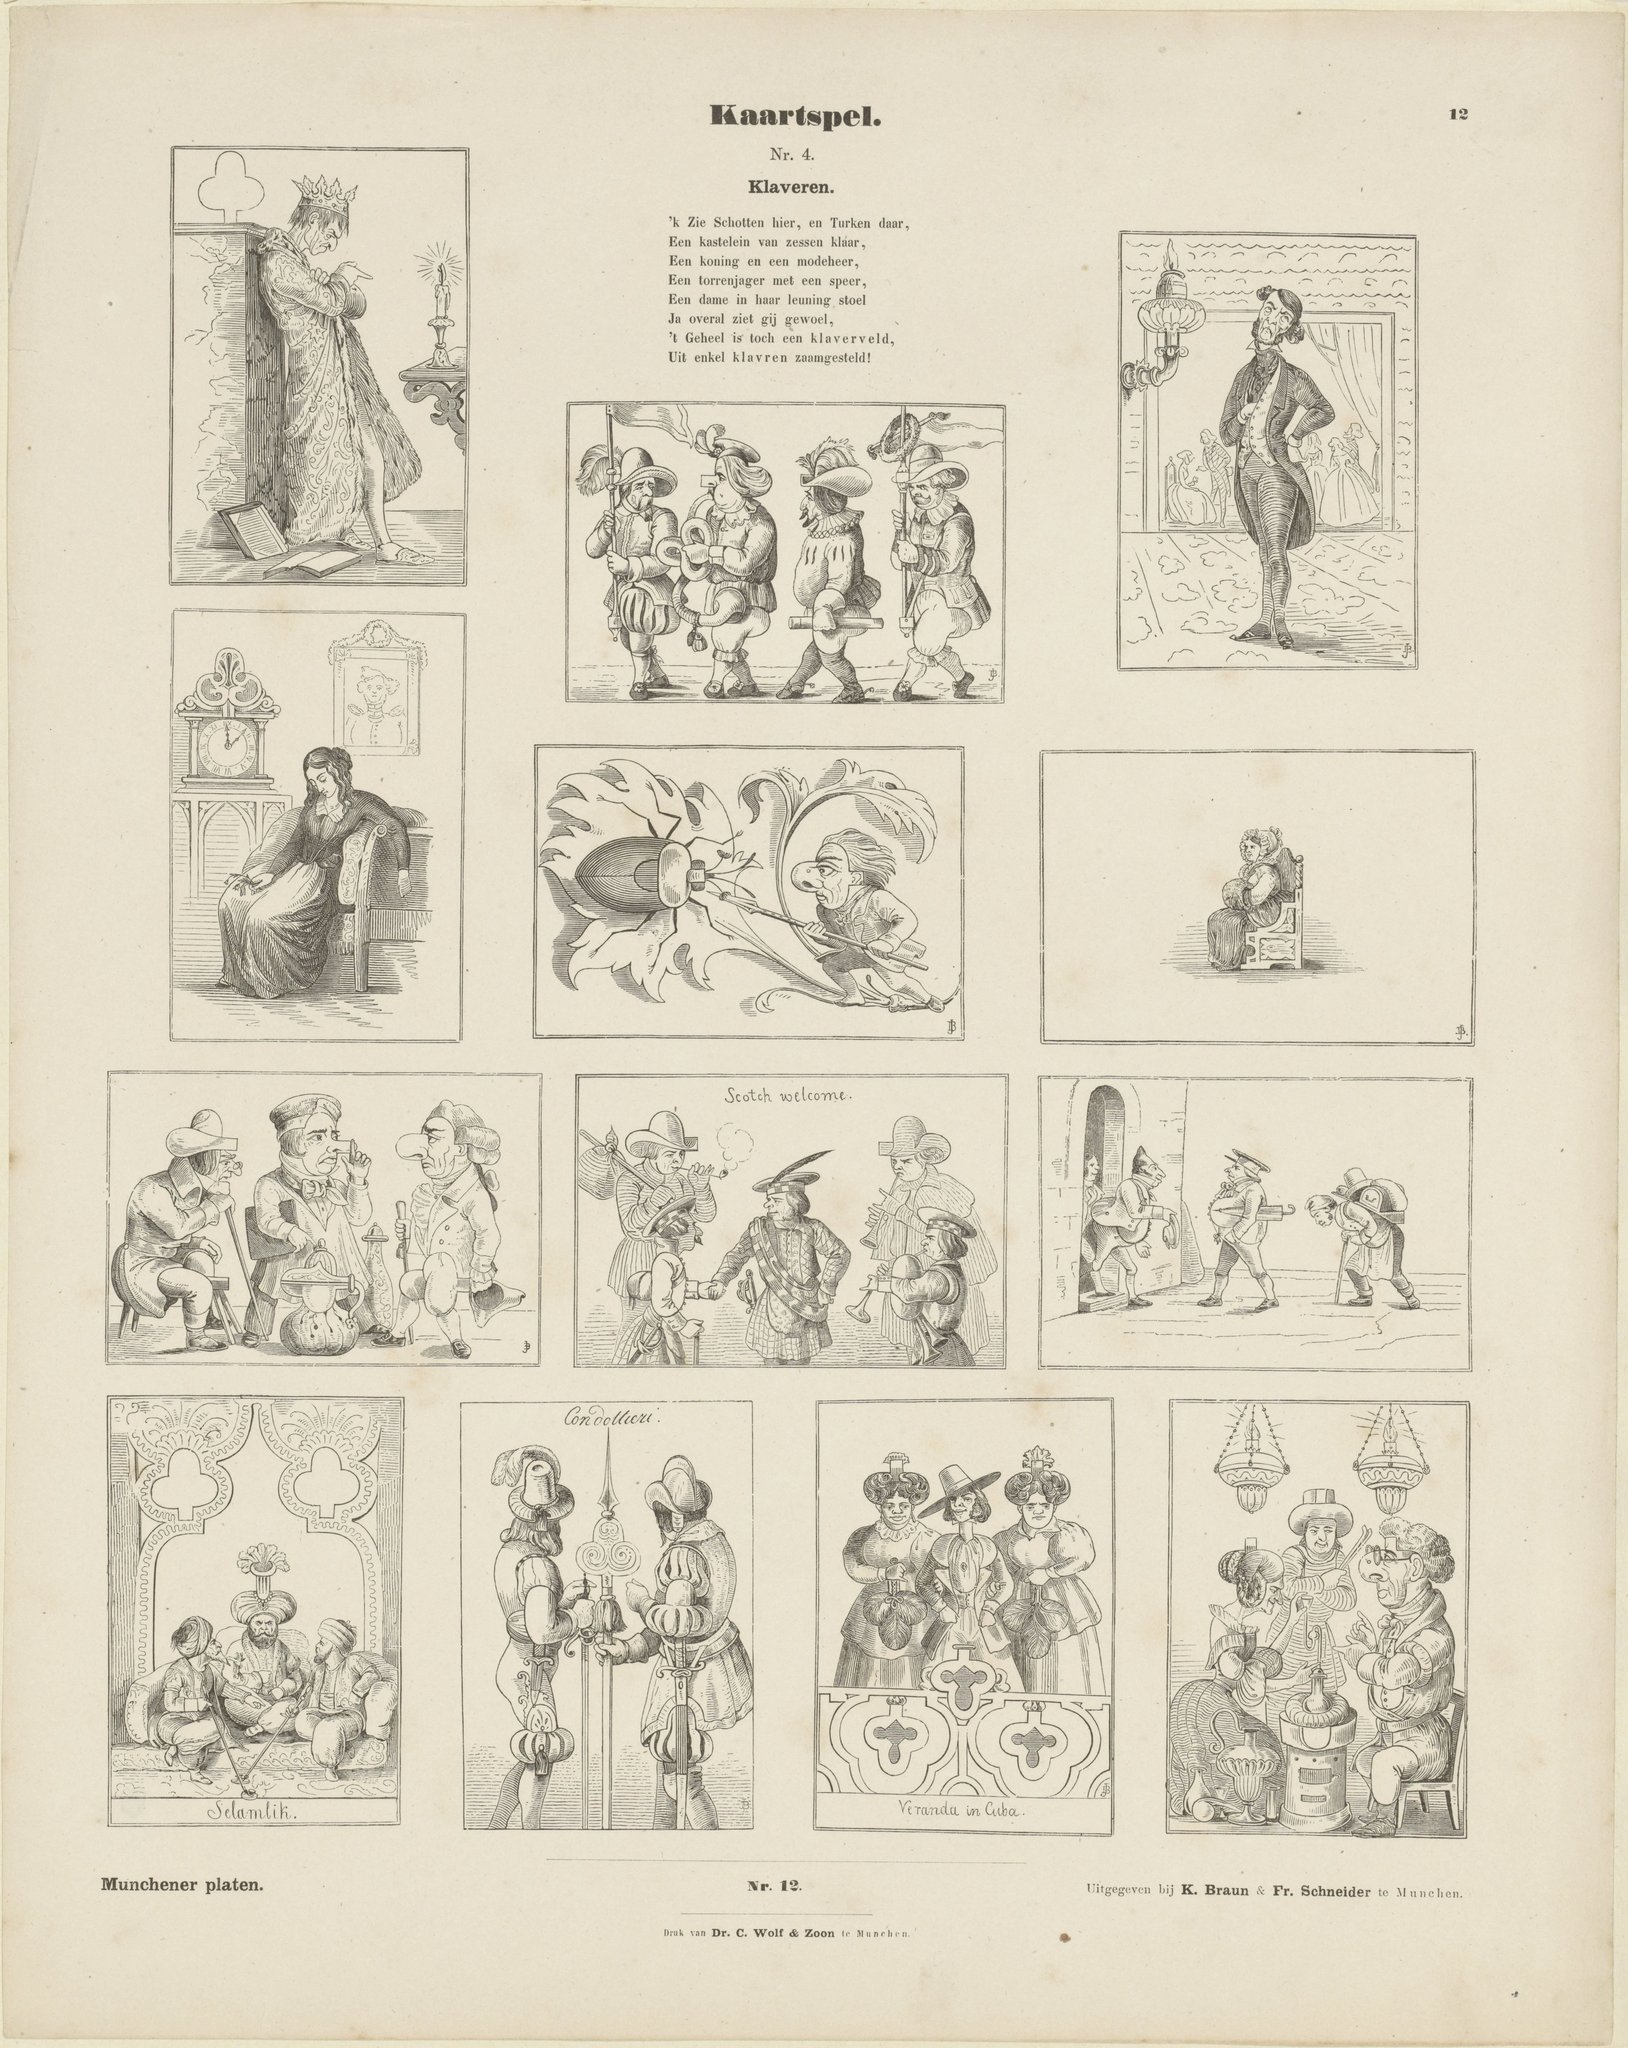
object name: print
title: Kaartspel. / Nr. 4. / Klaveren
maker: j. beeg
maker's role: draughtsman, print maker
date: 1843-1920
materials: paper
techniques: letterpress printing, engraving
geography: germany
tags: playing-cards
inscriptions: collector's mark: Lugt 2760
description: Blad met 13 voorstellingen van speelkaarten (klaveren), met verschillende figuren. Onder de titel een achtregelig vers. Genummerd midden onder: Nr. 12. Genummerd rechtsboven: 12.